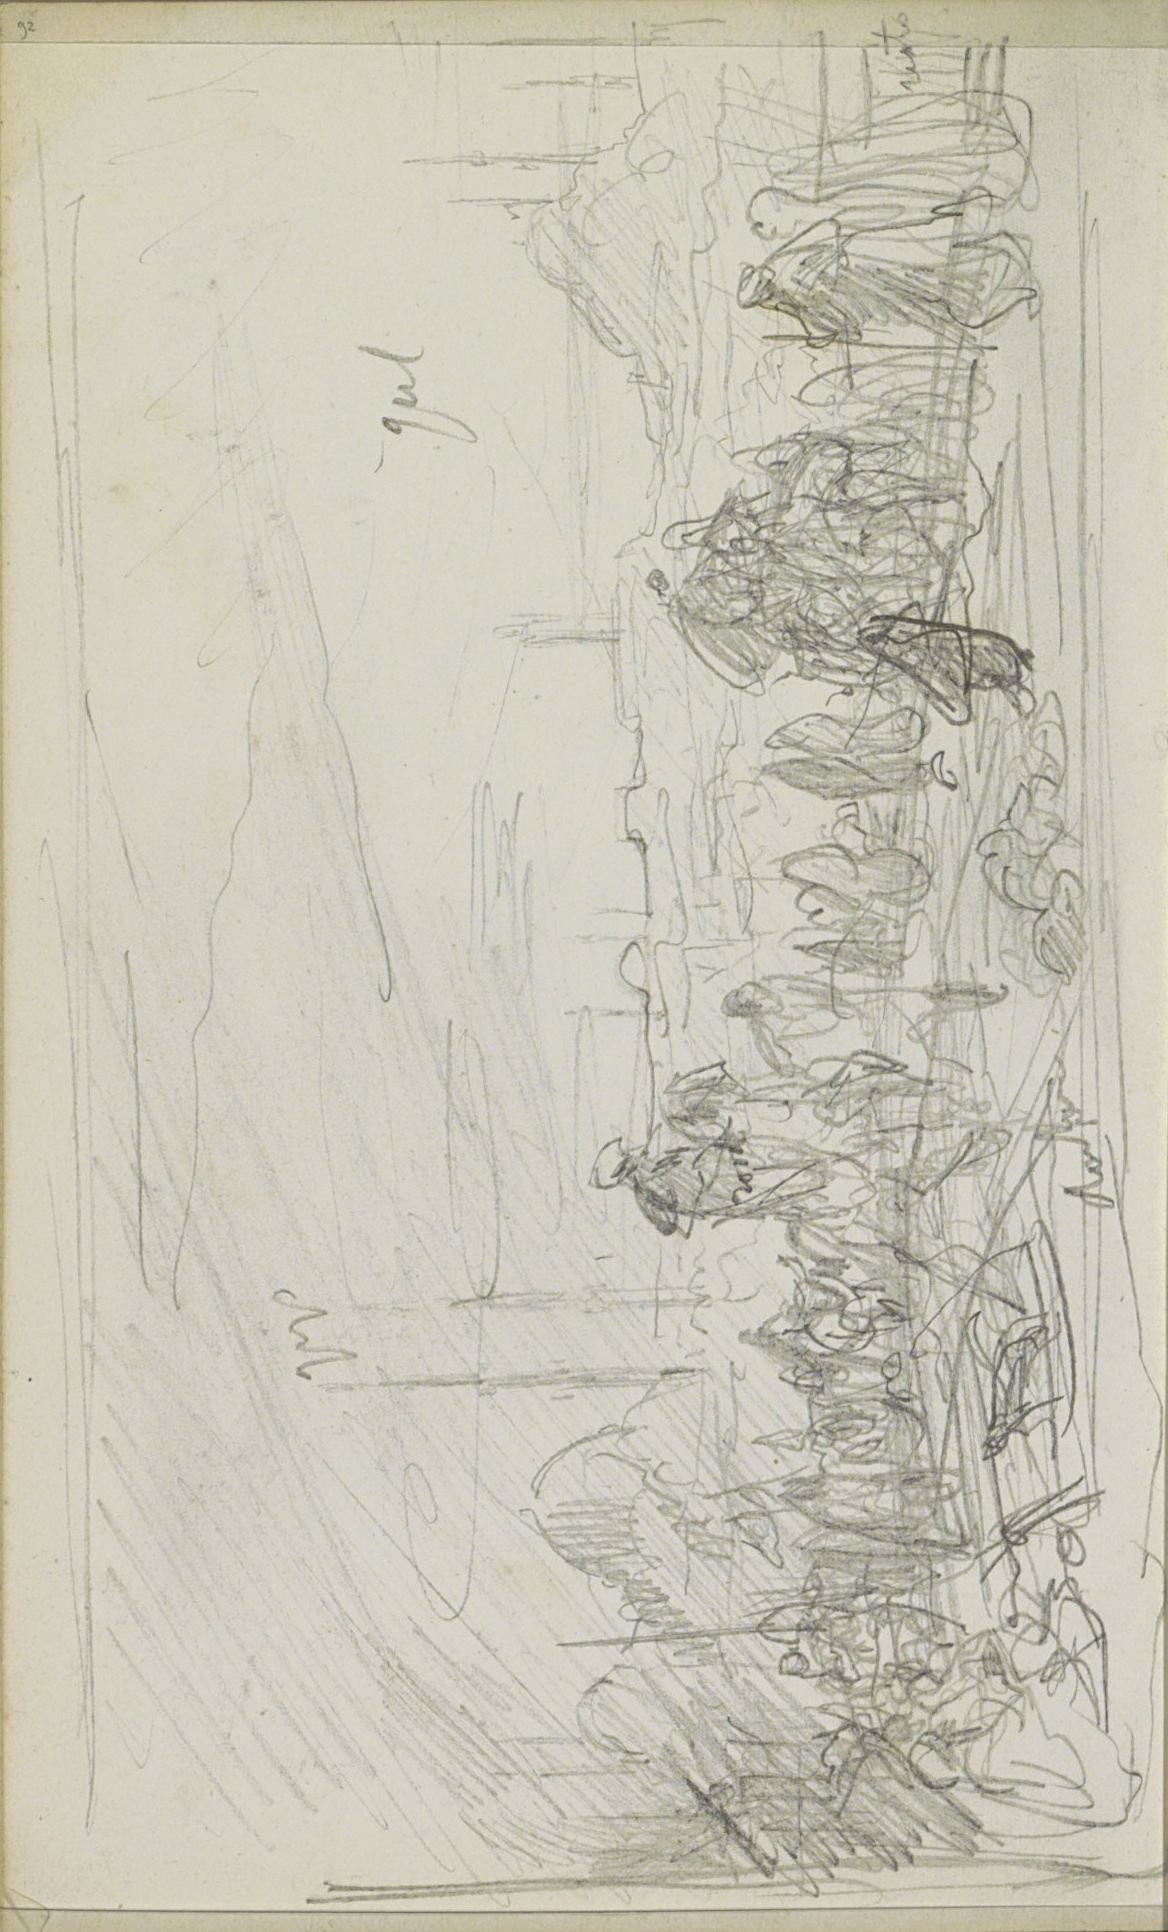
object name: sketchbook leaf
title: Gezicht op Caïro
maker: marius bauer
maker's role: draughtsman, print maker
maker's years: 1867-1932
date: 1904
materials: paper, pencil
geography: cairo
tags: city-view, and landscape with man-made constructions, africans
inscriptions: kleurnotitie, handgeschreven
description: Op de voorgrond een groep staande en zittende Egyptenaren op een open plek met uitzicht over de stad. Pagina 92 uit een schetsboek met 56 bladen.